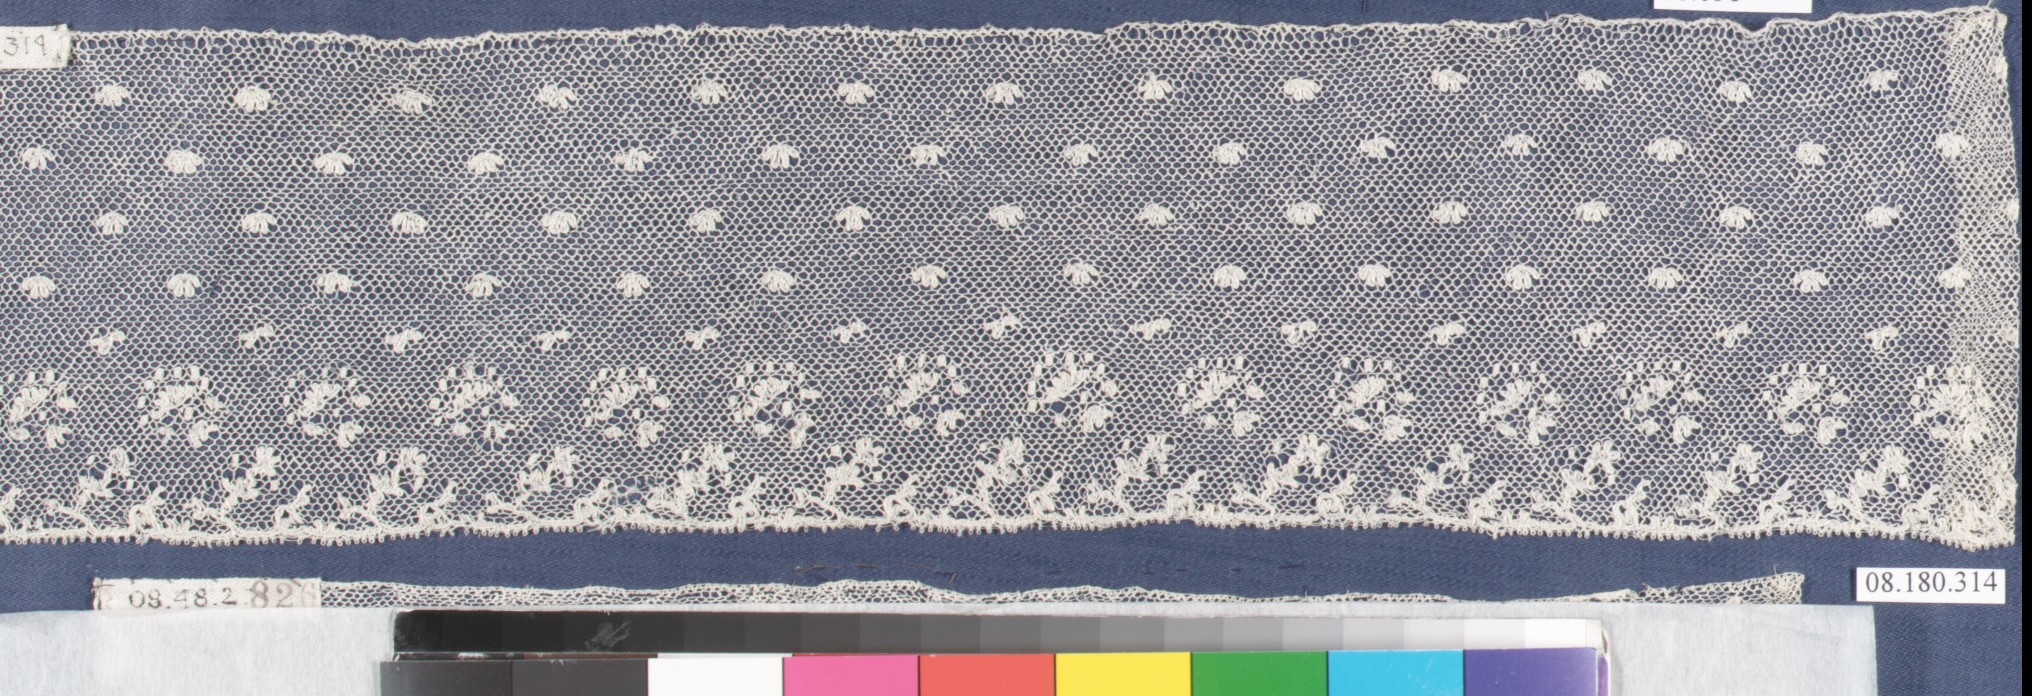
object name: piece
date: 1801-1833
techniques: lace